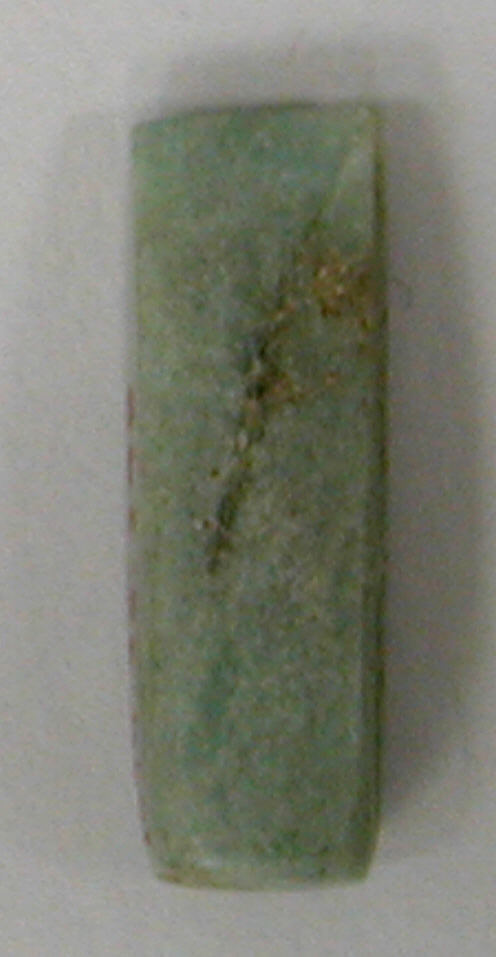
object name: celt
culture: mexican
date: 1501-1600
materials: stone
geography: mexico